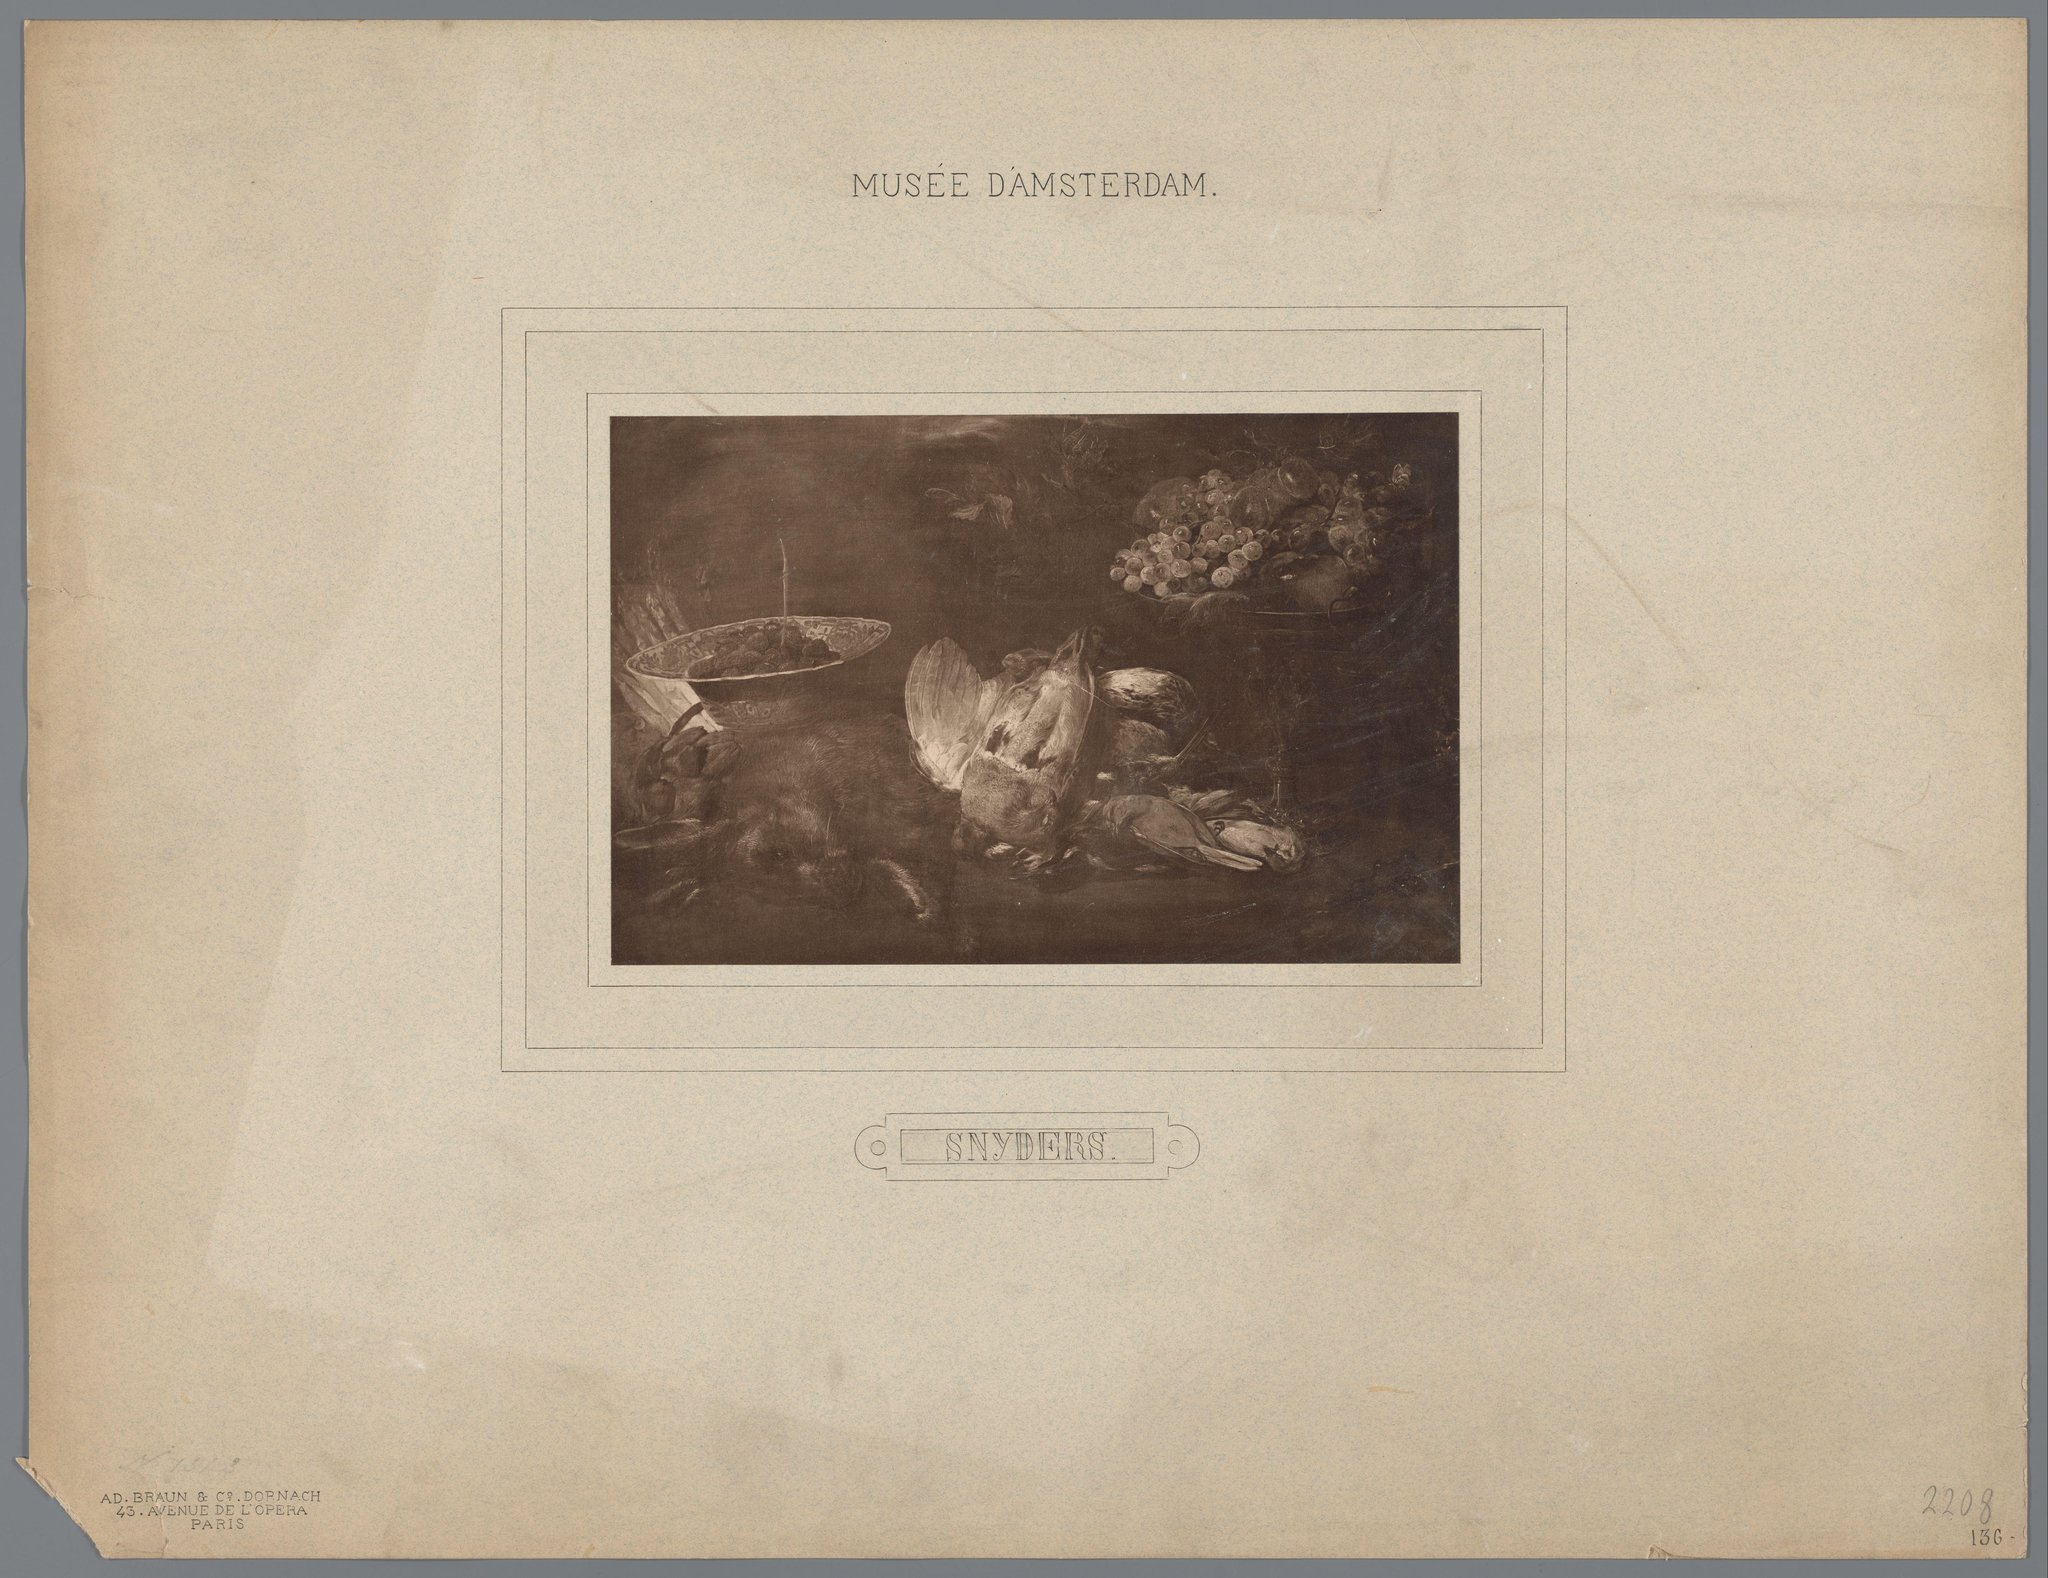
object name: photograph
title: Fotoreproductie van een schilderij van Frans Snijders, 'Stilleven met klein dood wild en vruchten' (coll. Rijksmuseum)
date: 1880-1900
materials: cardboard, paper, photographic support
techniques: carbon print